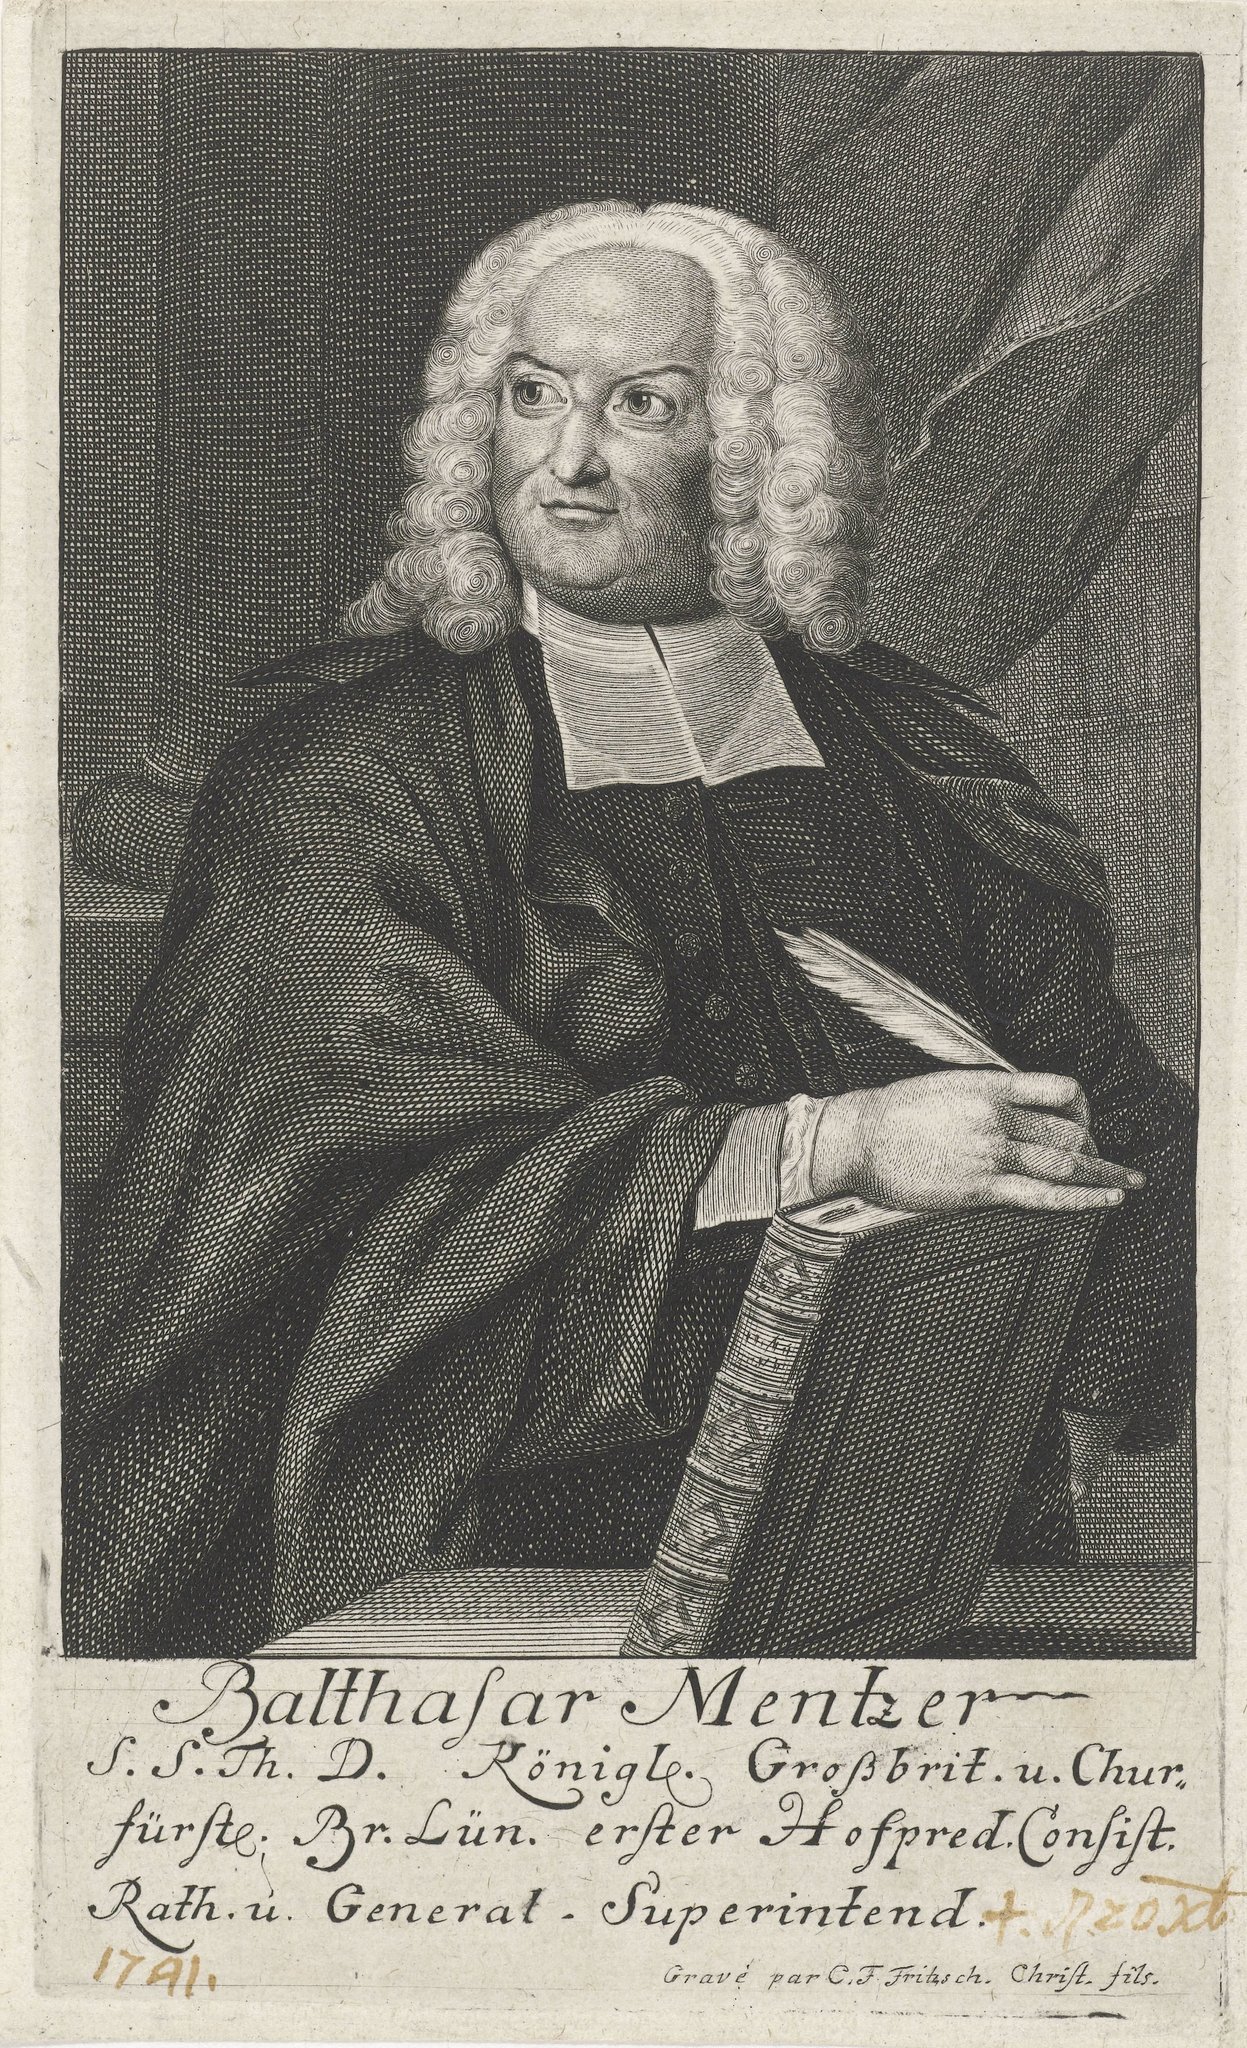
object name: print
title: Portret van Balthasar Mentzer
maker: christian friedrich fritzsch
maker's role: print maker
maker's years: 1719-1774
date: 1722-1774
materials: paper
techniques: engraving, etching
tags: balthasar mentzer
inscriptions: collector's mark: Lugt 2228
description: De theoloog Balthasar Mentzer, staand bij een tafel, schrijfveer in de rechterhand die rust op een boek. In de marge onder het portret staan zijn naam en titels in het Duits.